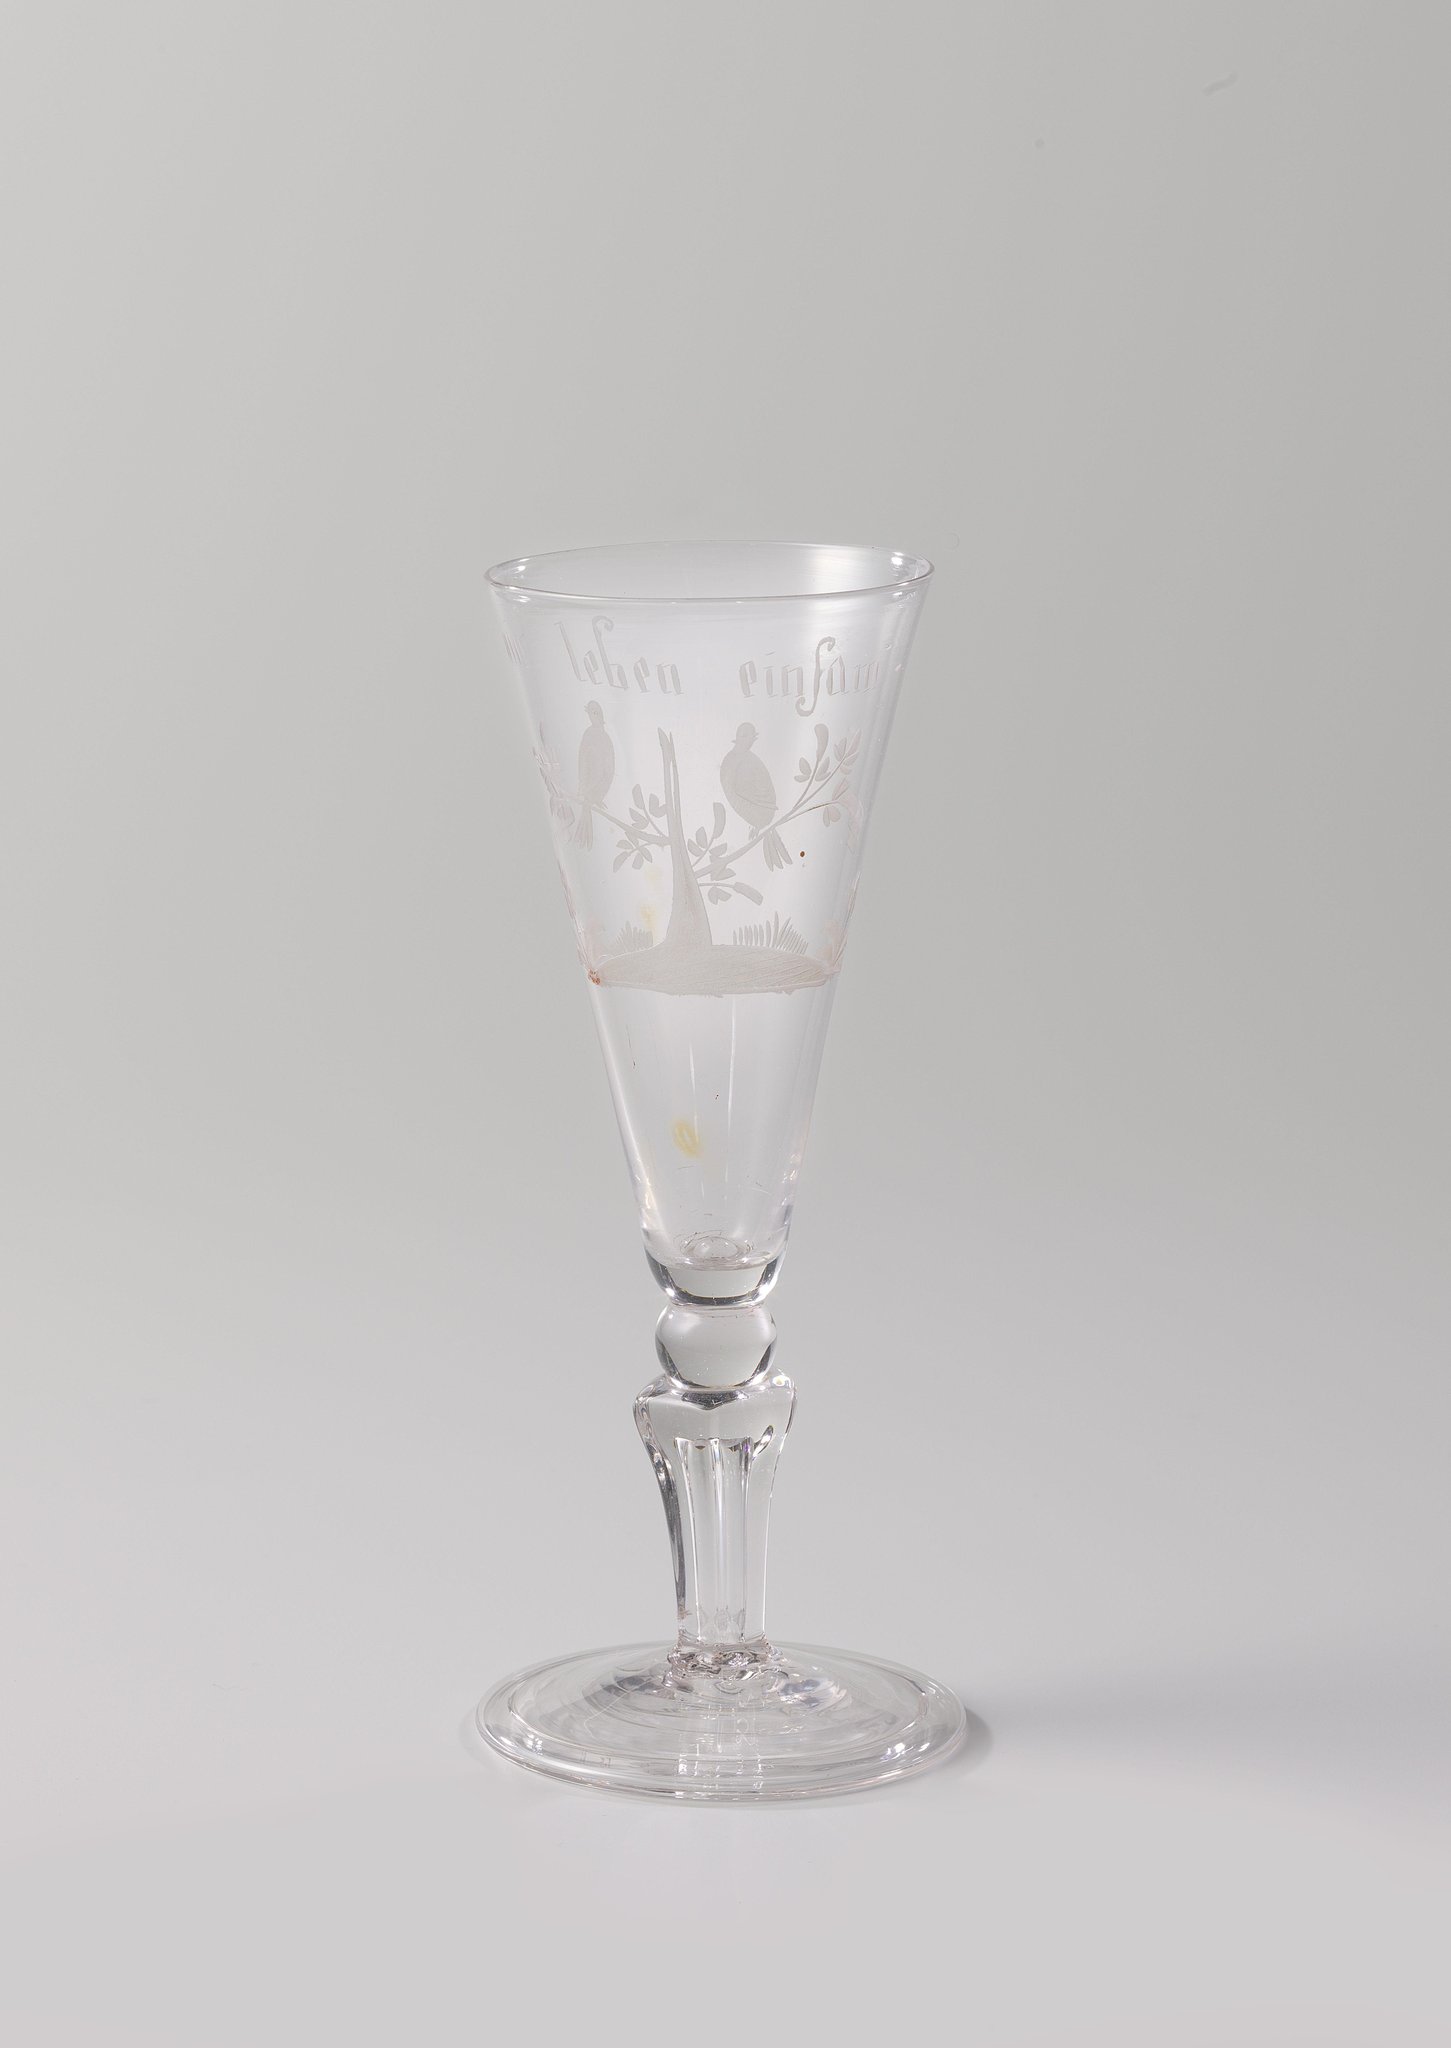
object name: goblet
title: Kelkglas met vogels in een boom en het opschrift: WIR LEBEN EINSAM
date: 1725-1775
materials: glass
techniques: glassblowing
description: Kelkglas, lang en slank, op vijfhoekige stam: tussen kelk en staam een schijf. Iets gewelfde voet met naar onderen omgeslagen rand. De kelk is versierd met een radgravure: twee vogels op de twee takken van een boom, waarboven het opschrift: WIR LEBEN EINSAM.